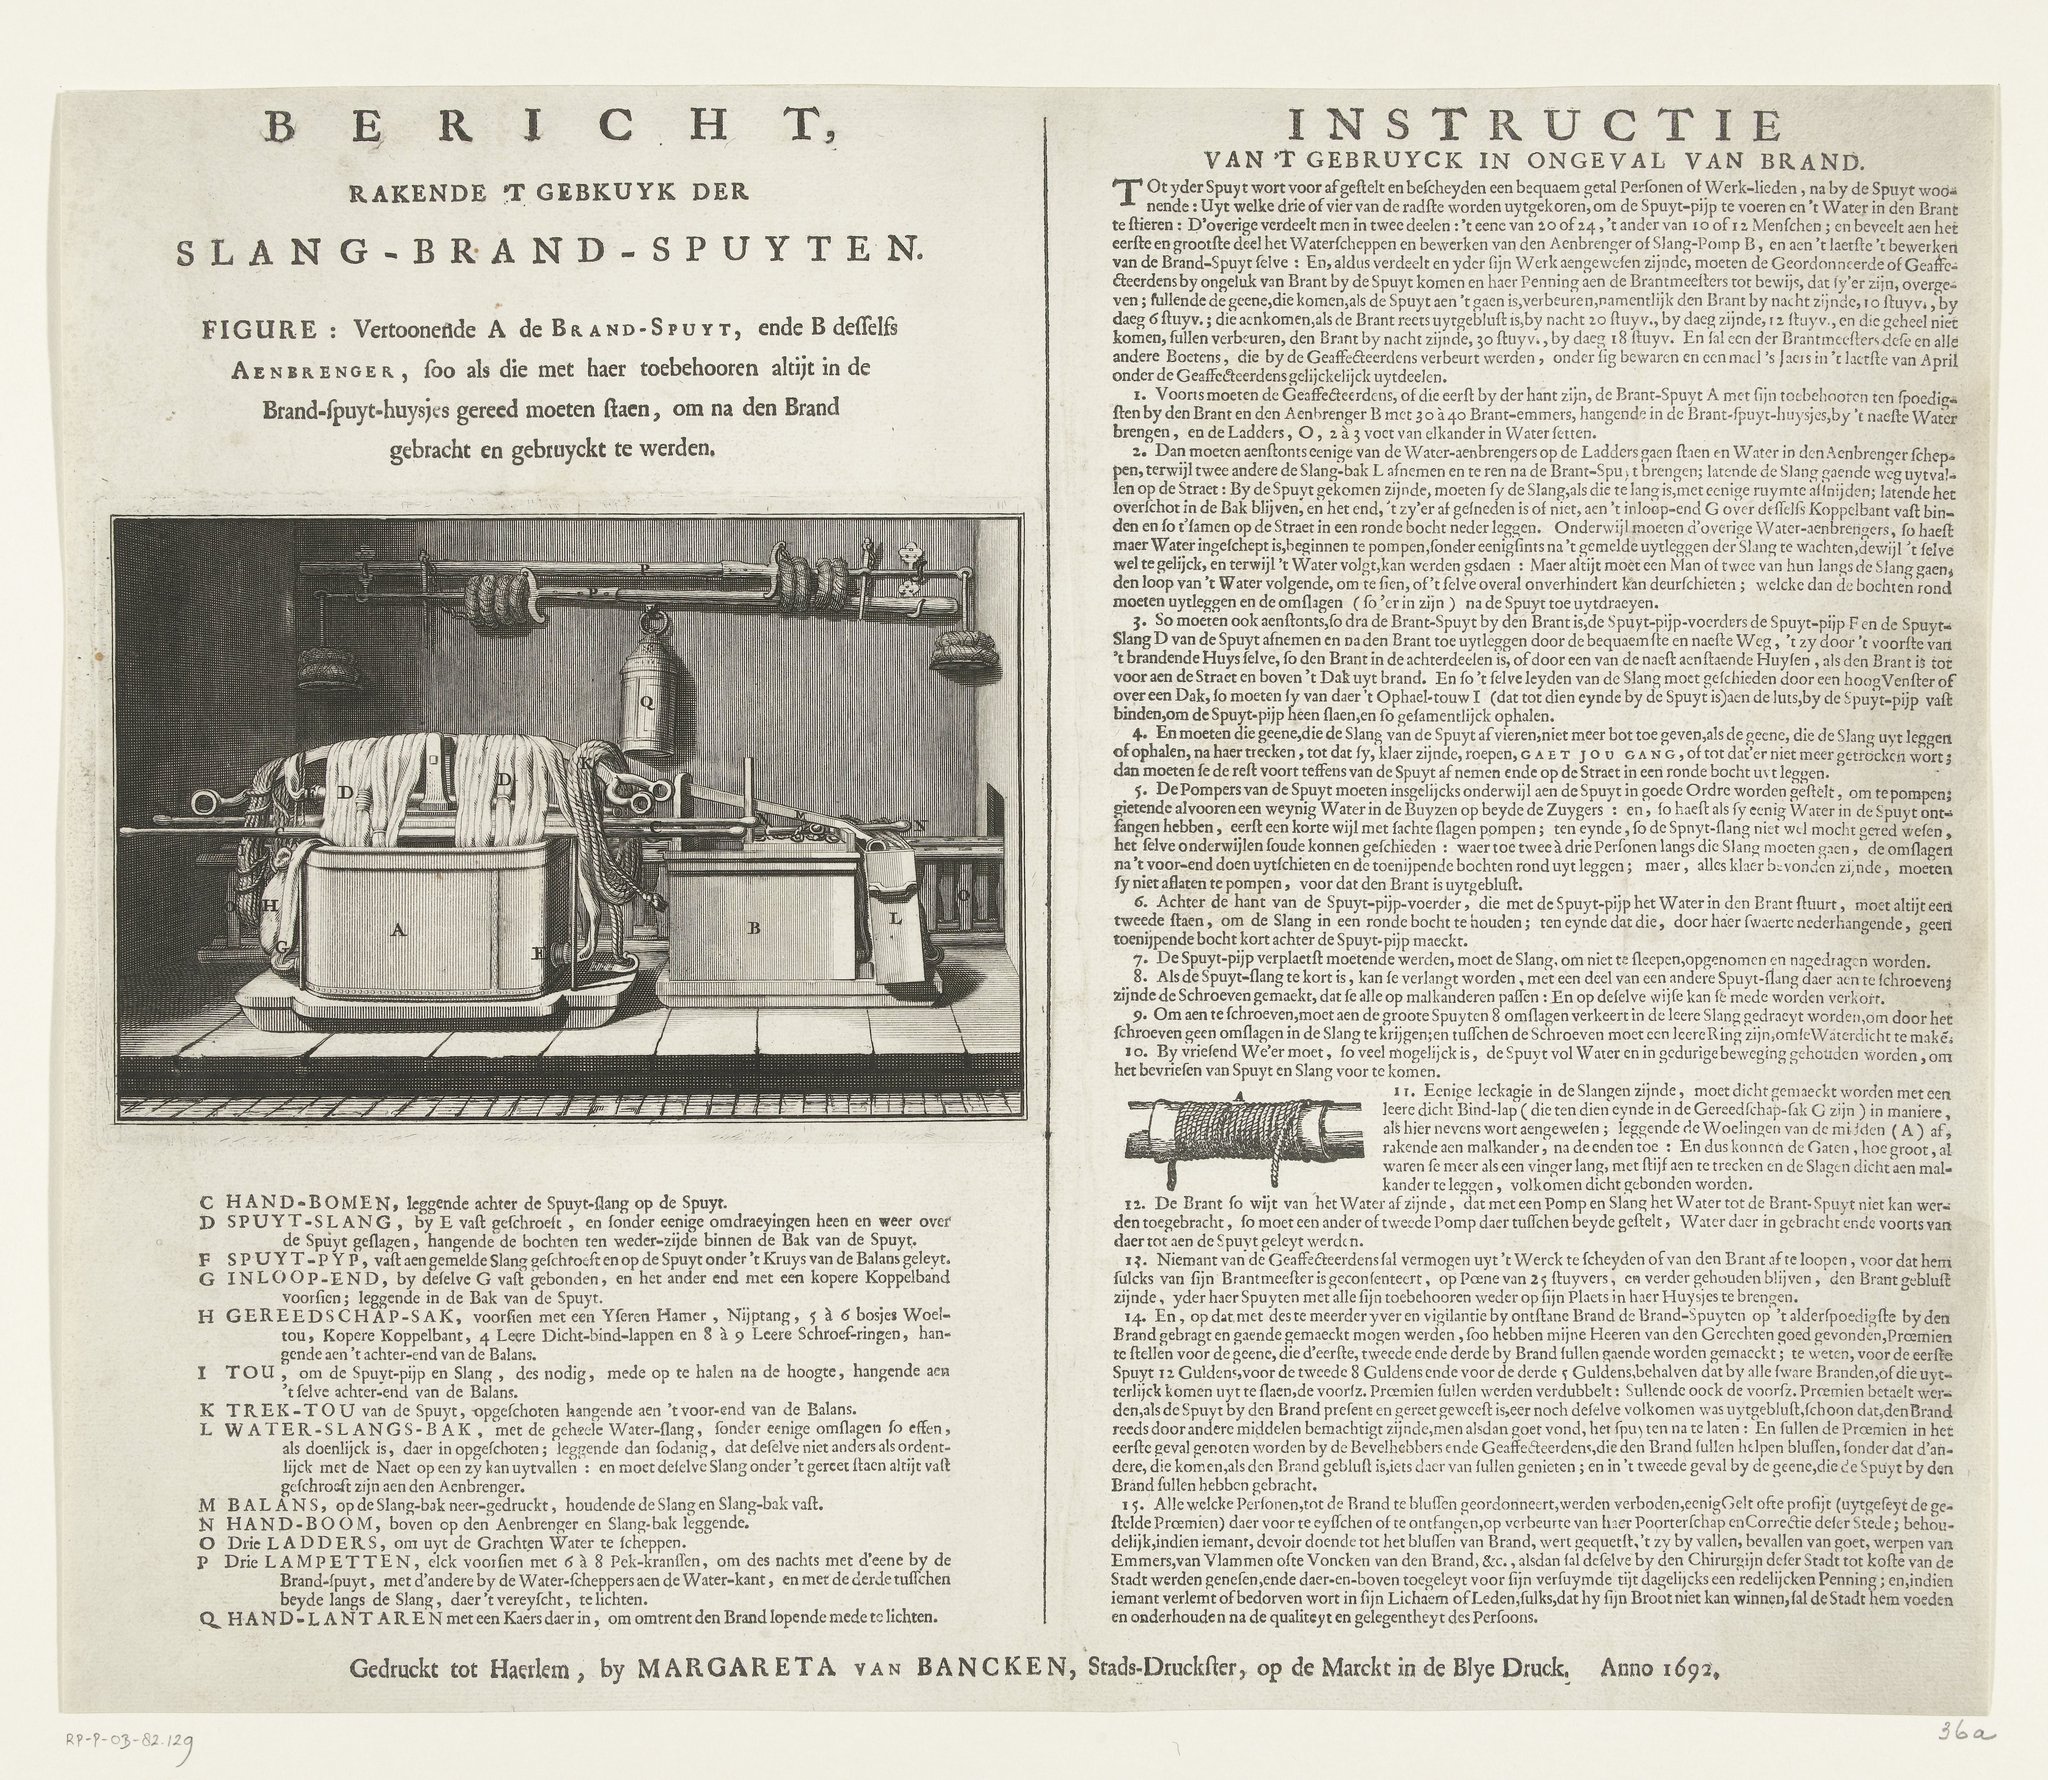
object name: print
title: Instructie over het gebruik van de slangbrandspuiten, 1692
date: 1692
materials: paper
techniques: etching, letterpress printing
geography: northern netherlands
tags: painter, print maker, draughtsman, jan van der heyden, fire-extinguishing equipment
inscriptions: date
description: Blad met een instructie over het correcte gebruik en bewaring van de slangbrandspuiten, 1692. Links een voorstelling hoe de slangbrandspuit en pomp in het brandspuithuisje opgeborgen dienen te worden na gebruik, met de legenda A-Q. Rechts een tekstblad met de instructie voor gebruik in het geval van brand in 15 punten en een plaatje hoe een lekkage in een slang gerepareerd dient te worden. Behoort tot de bijprenten bij het Brandspuitenboek van Jan van der Heyden.